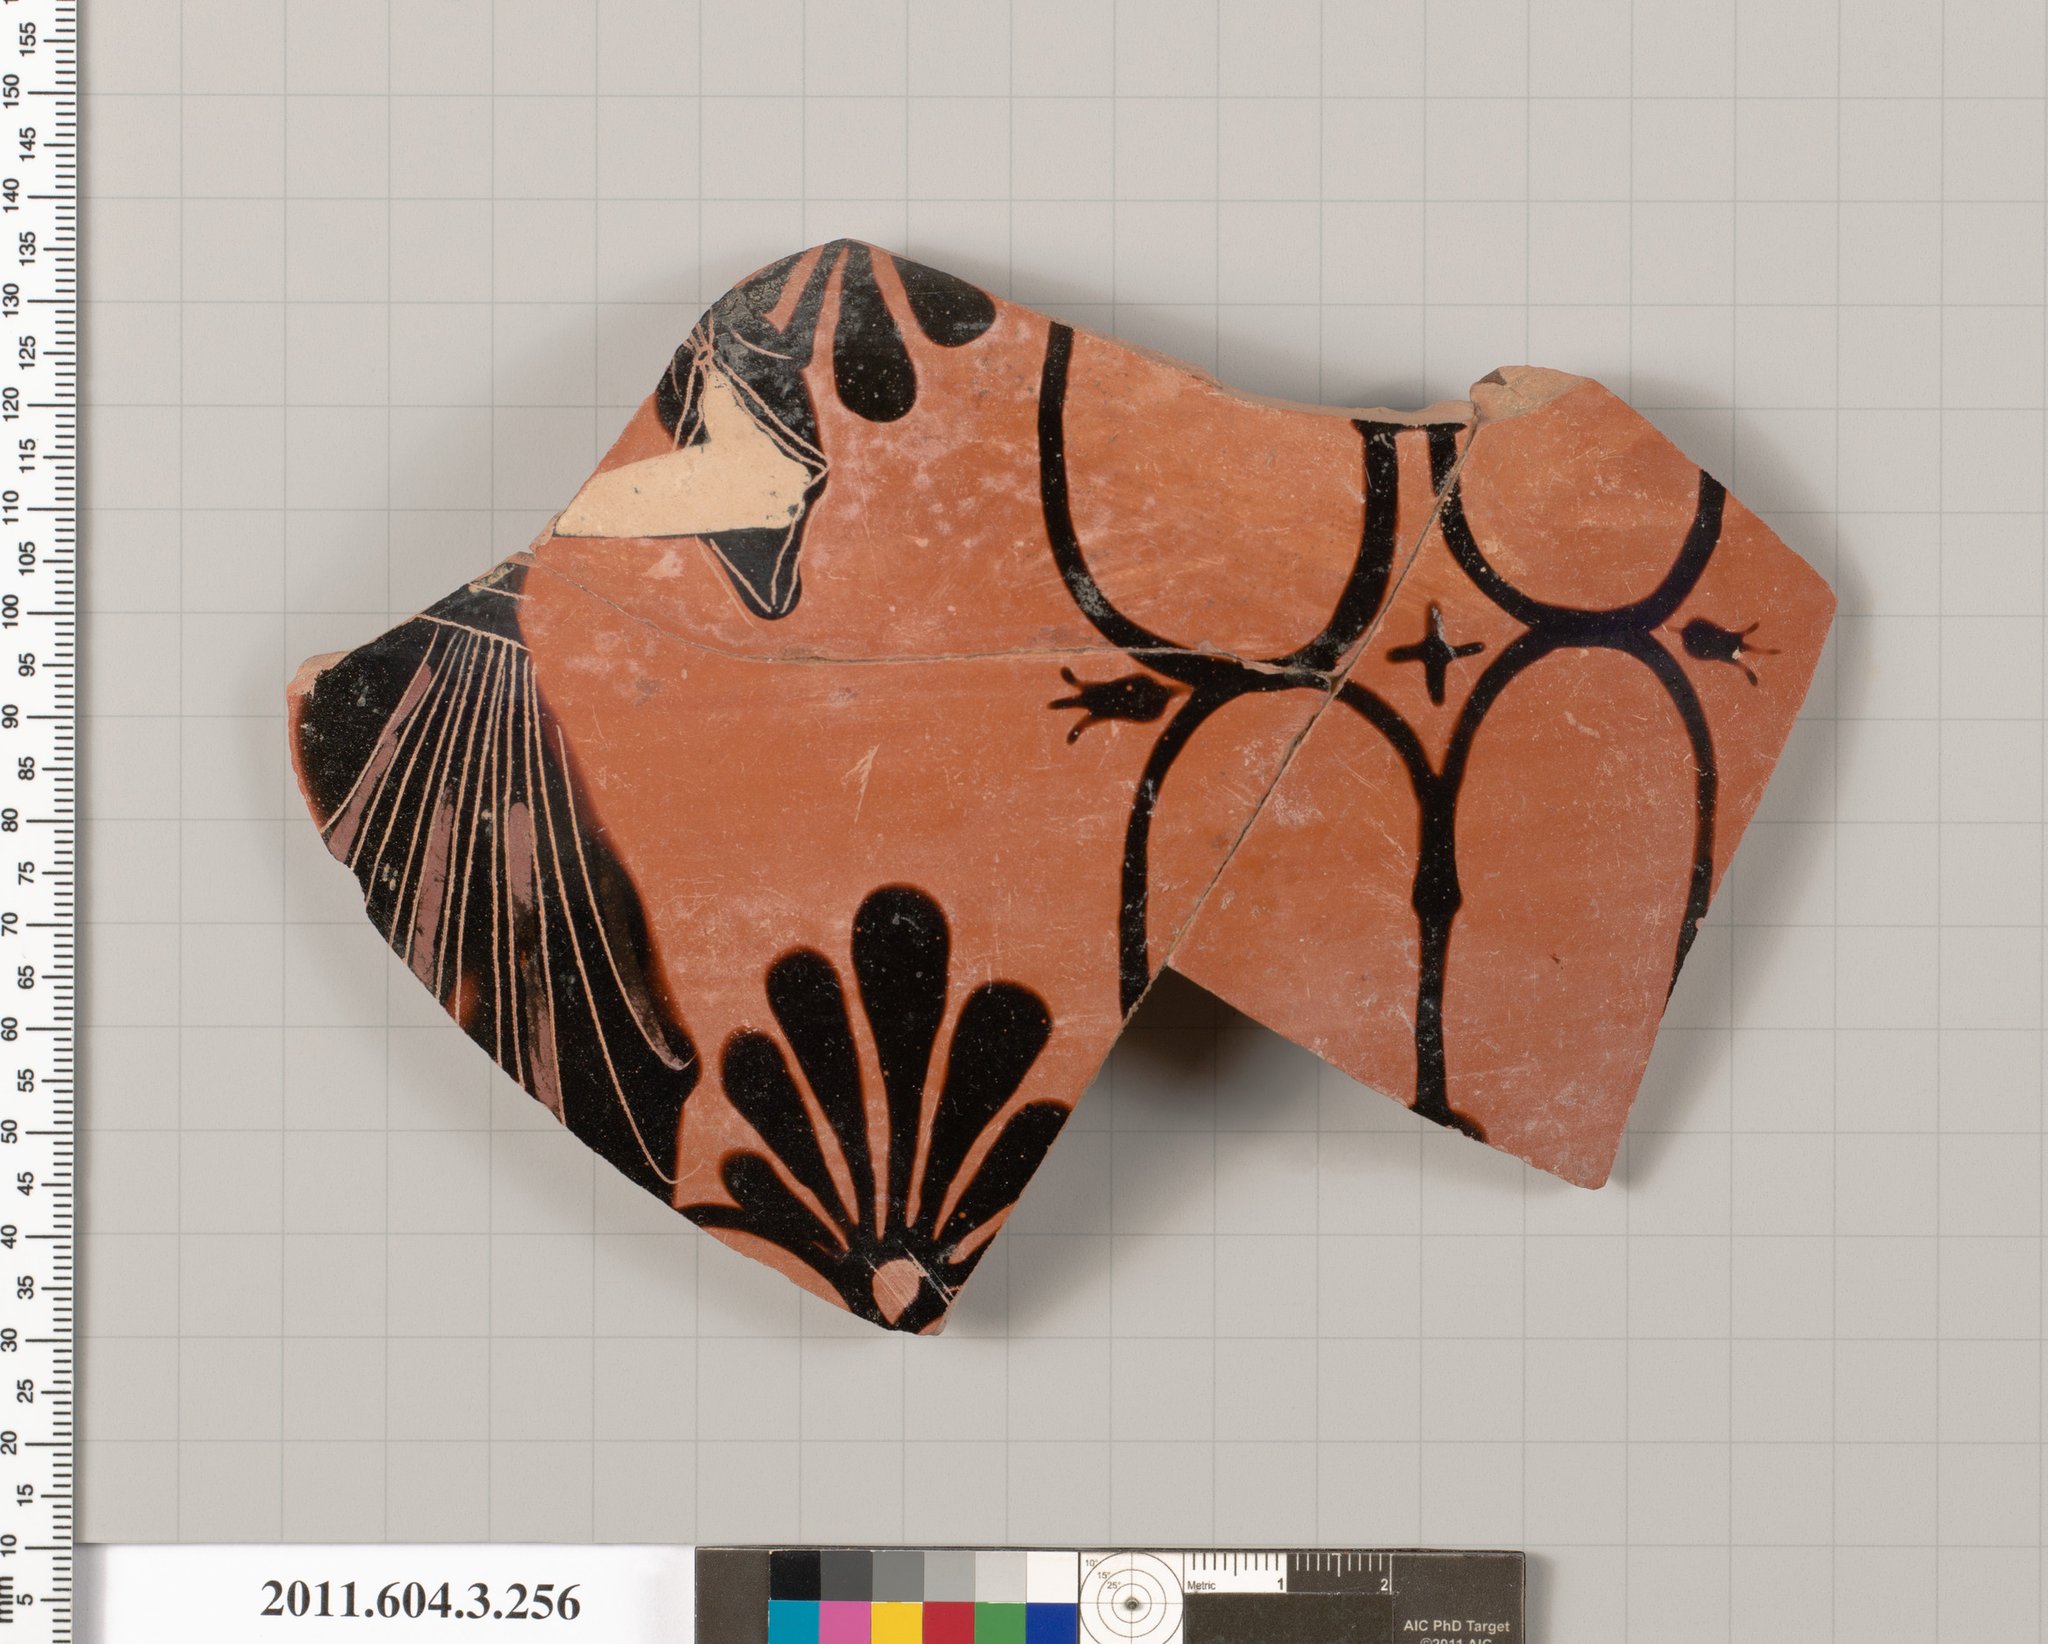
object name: neck amphora fragment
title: Terracotta fragment of a neck-amphora (jar)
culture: greek, attic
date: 530-520 BCE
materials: terracotta